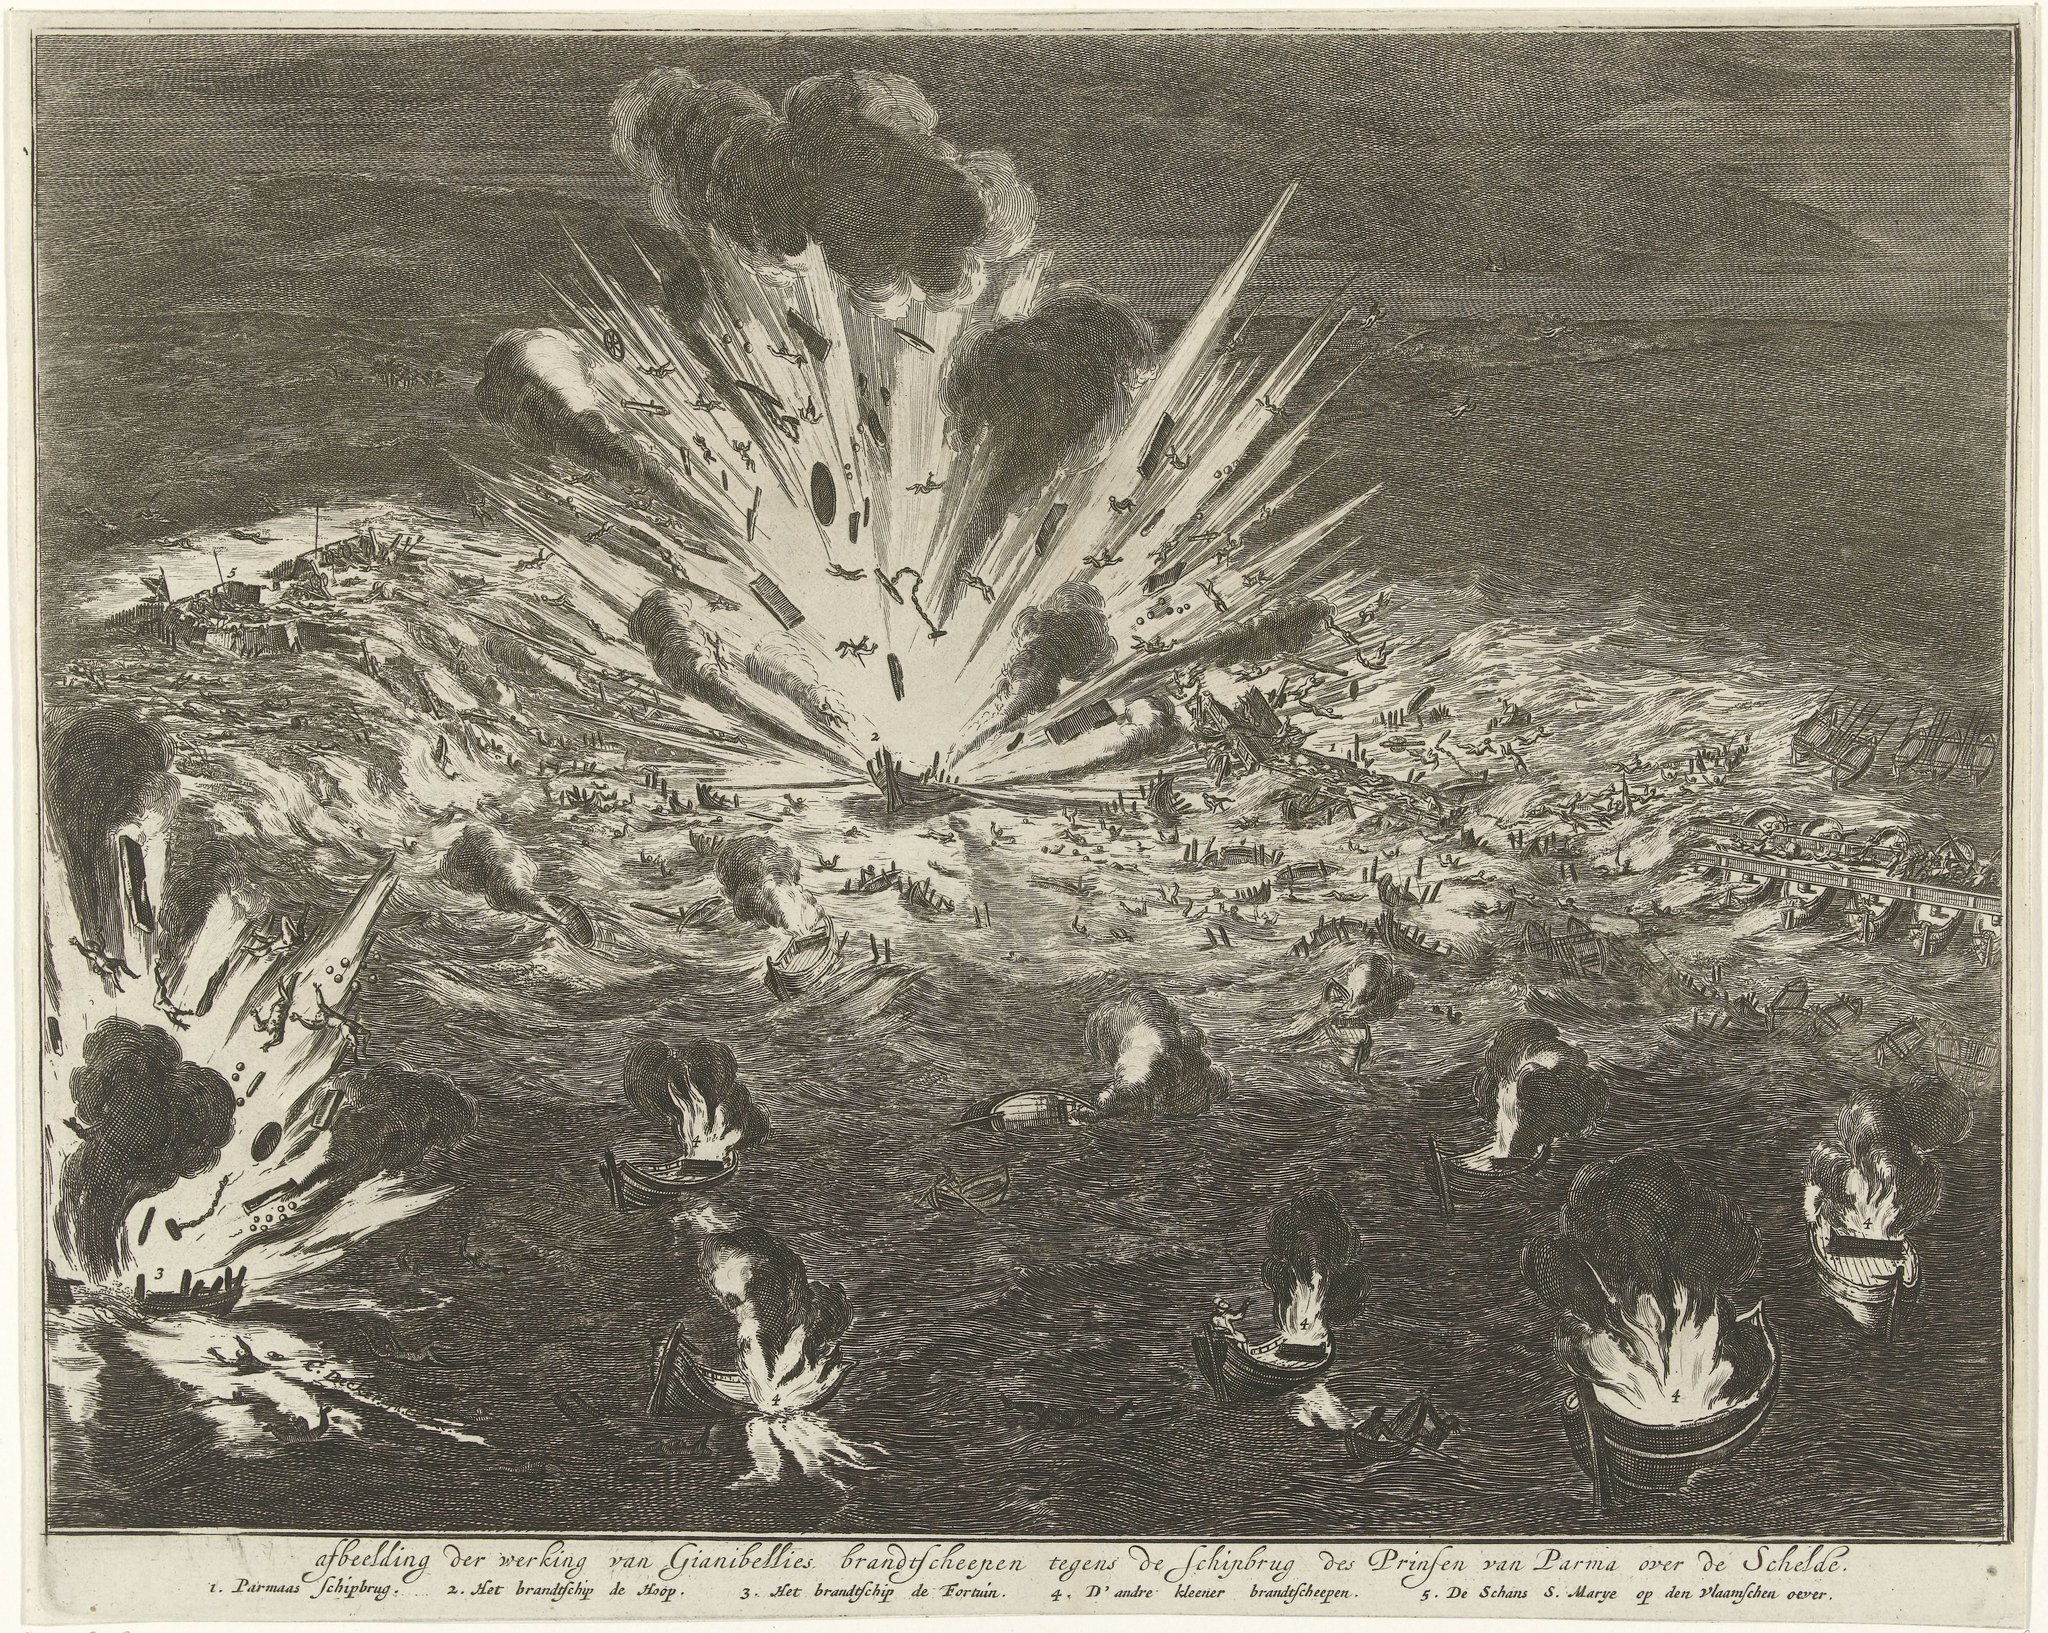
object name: history print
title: Afbeelding der werking van Gianibellies brandtscheepen tegens de schipbrug des prinsen van Parma over de Schelde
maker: coenraet decker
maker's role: print maker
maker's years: 1650-1685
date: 1677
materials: paper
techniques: engraving, etching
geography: amsterdam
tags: engineer, rome, alessandro farnese (landvoogd van de nederlanden en hertog van parma en piacenza), pontoon bridge, antwerp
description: Prent ook gebruikt in: P.C. Hoofts Nederlandsche historien, seedert de ooverdraght der heerschappye van kaizar Karel den Vyfden op koning Philips zynen zoon, tot het einde der landtvooghdye des graven van Leicester. 4e druk. 2 delen. Amsterdam: Hendrik Wetstein en Pieter Sceperus, Leiden: Daniel van den Dalen en Utrecht: Willem van de Water, 1703, dl. 2, p. 1002-1003. Voor eerste staat zie: RP-P-OB-79.983. Voor derde staat zie: RP-P-OB-79.984.